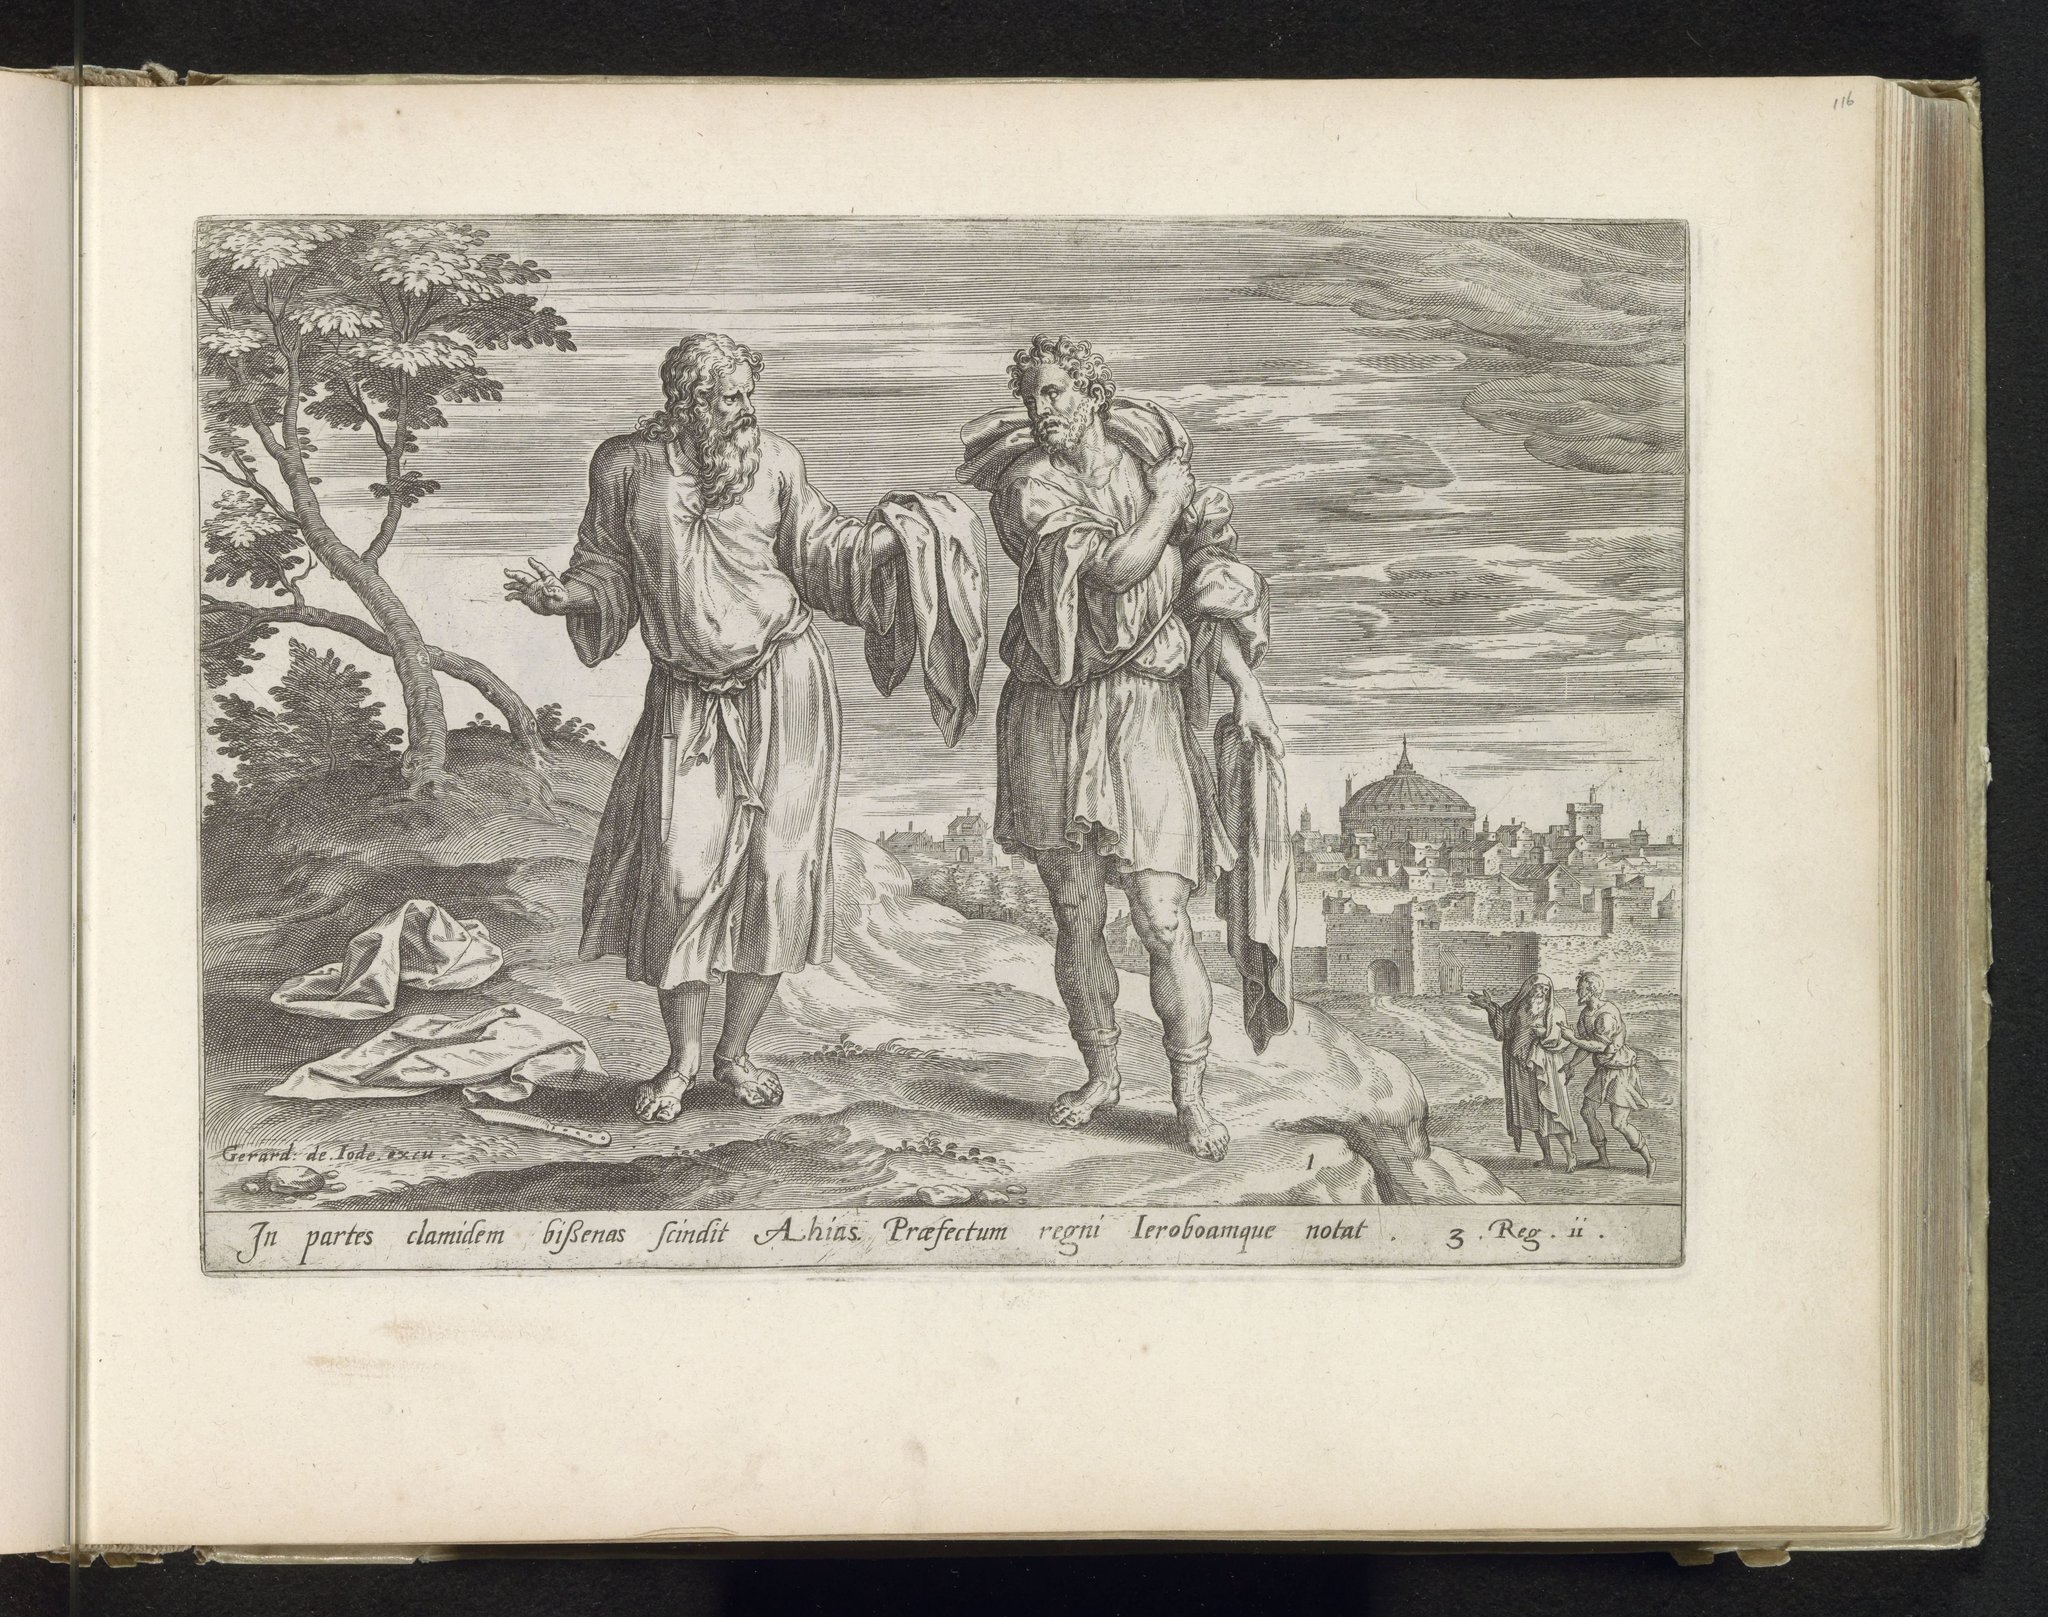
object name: album leaf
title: Geschiedenis van Jerobeam en Rechabeam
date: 1585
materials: paper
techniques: engraving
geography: antwerp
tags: meeting of jeroboam and the prophet ahijah; ahijah rends his garment in twelve pieces, ten of which he gives to jeroboam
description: De profeet Achia heeft zijn mantel in twaalf stukken gescheurd en overhandigt tien stukken aan Jerobeam. De gescheurde mantel staat symbool voor de splitsing van het Joodse volk. Jerobeam werd koning van tien van de twaalf stammen. Onder de voorstelling een verwijzing in het Latijn naar de Bijbeltekst in 1 Kon. 11. Deze prent maakt deel uit van een album.